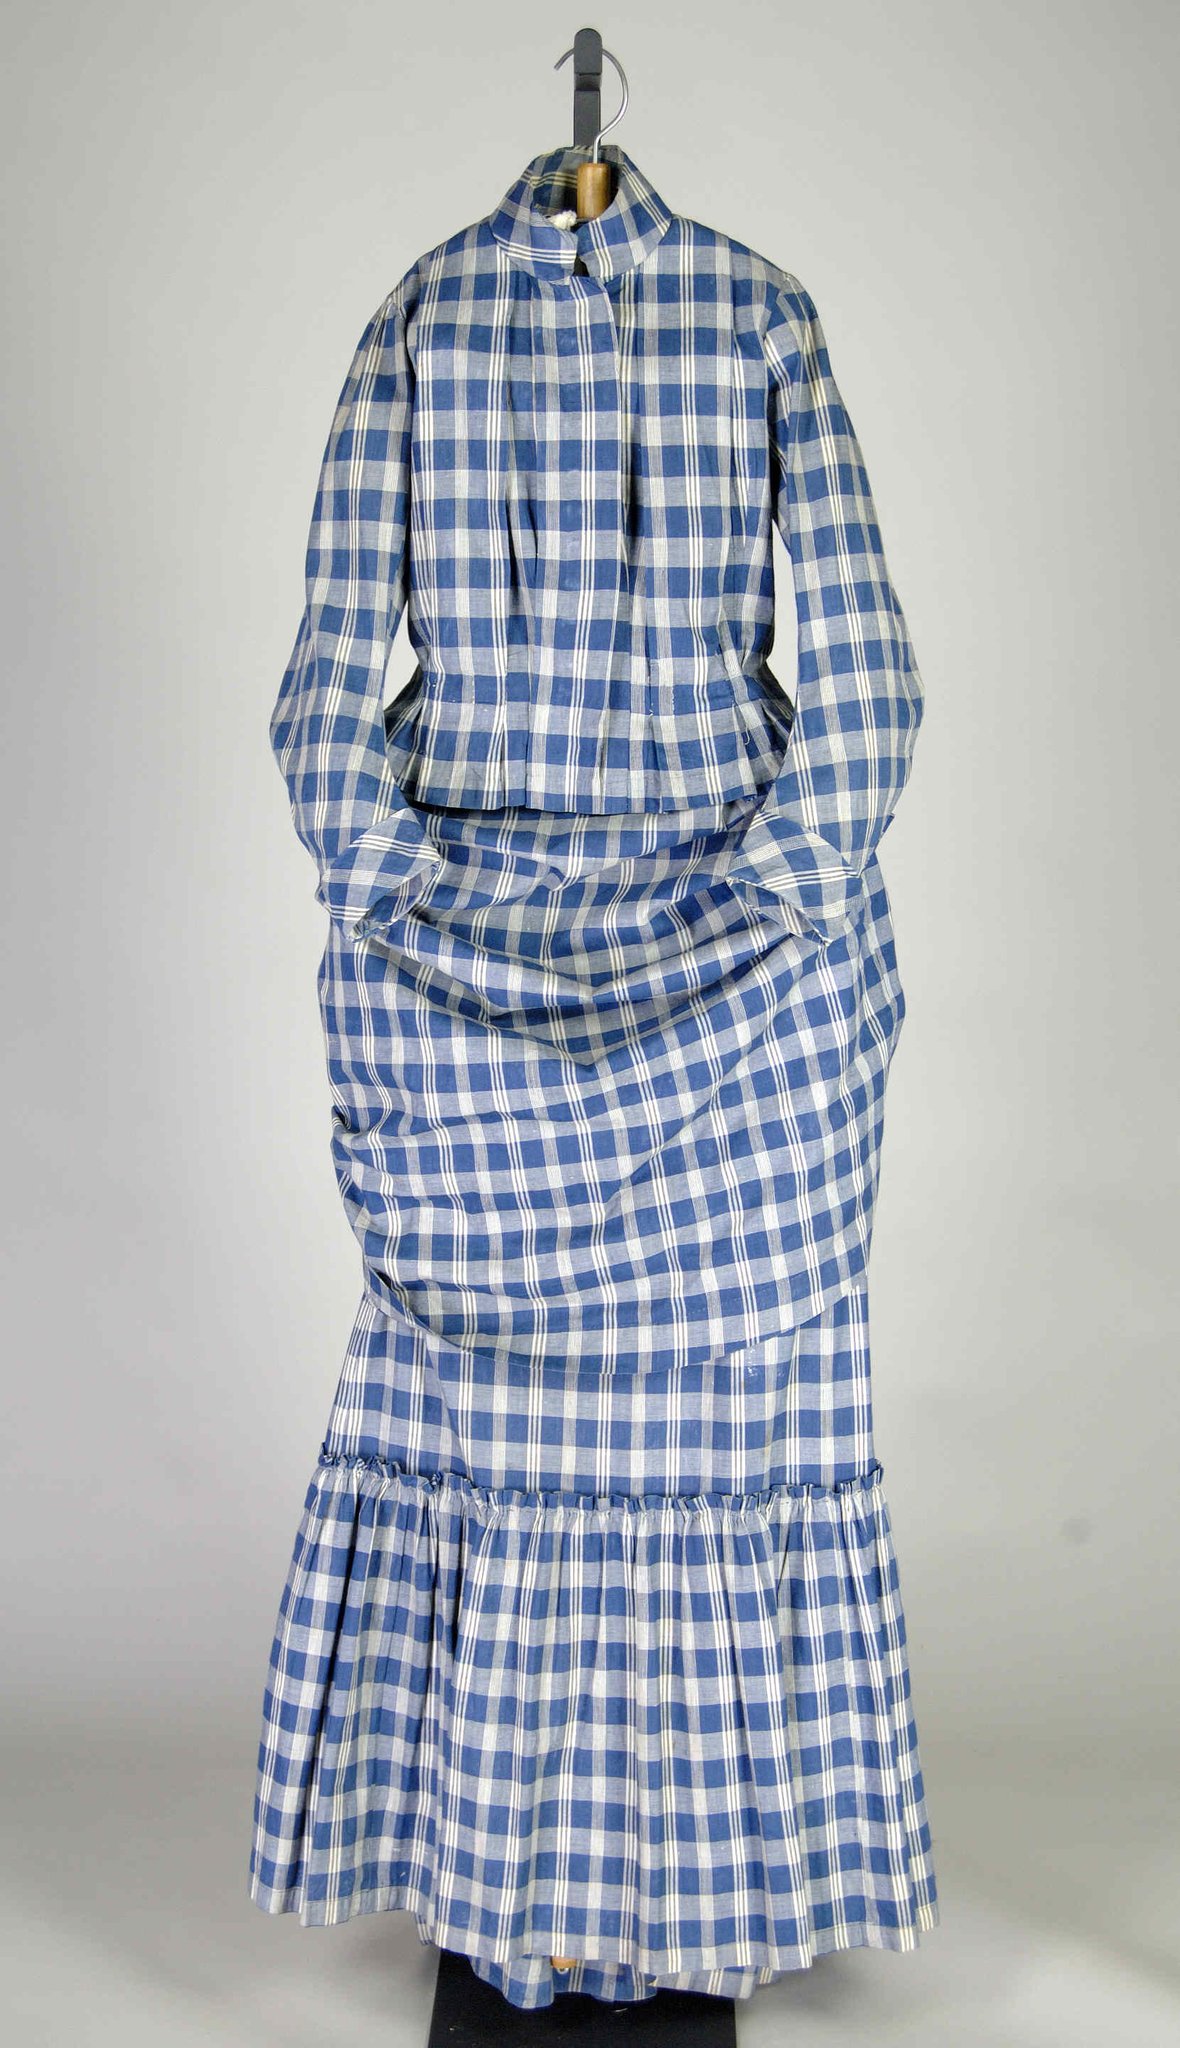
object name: morning dress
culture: american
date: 1885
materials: cotton